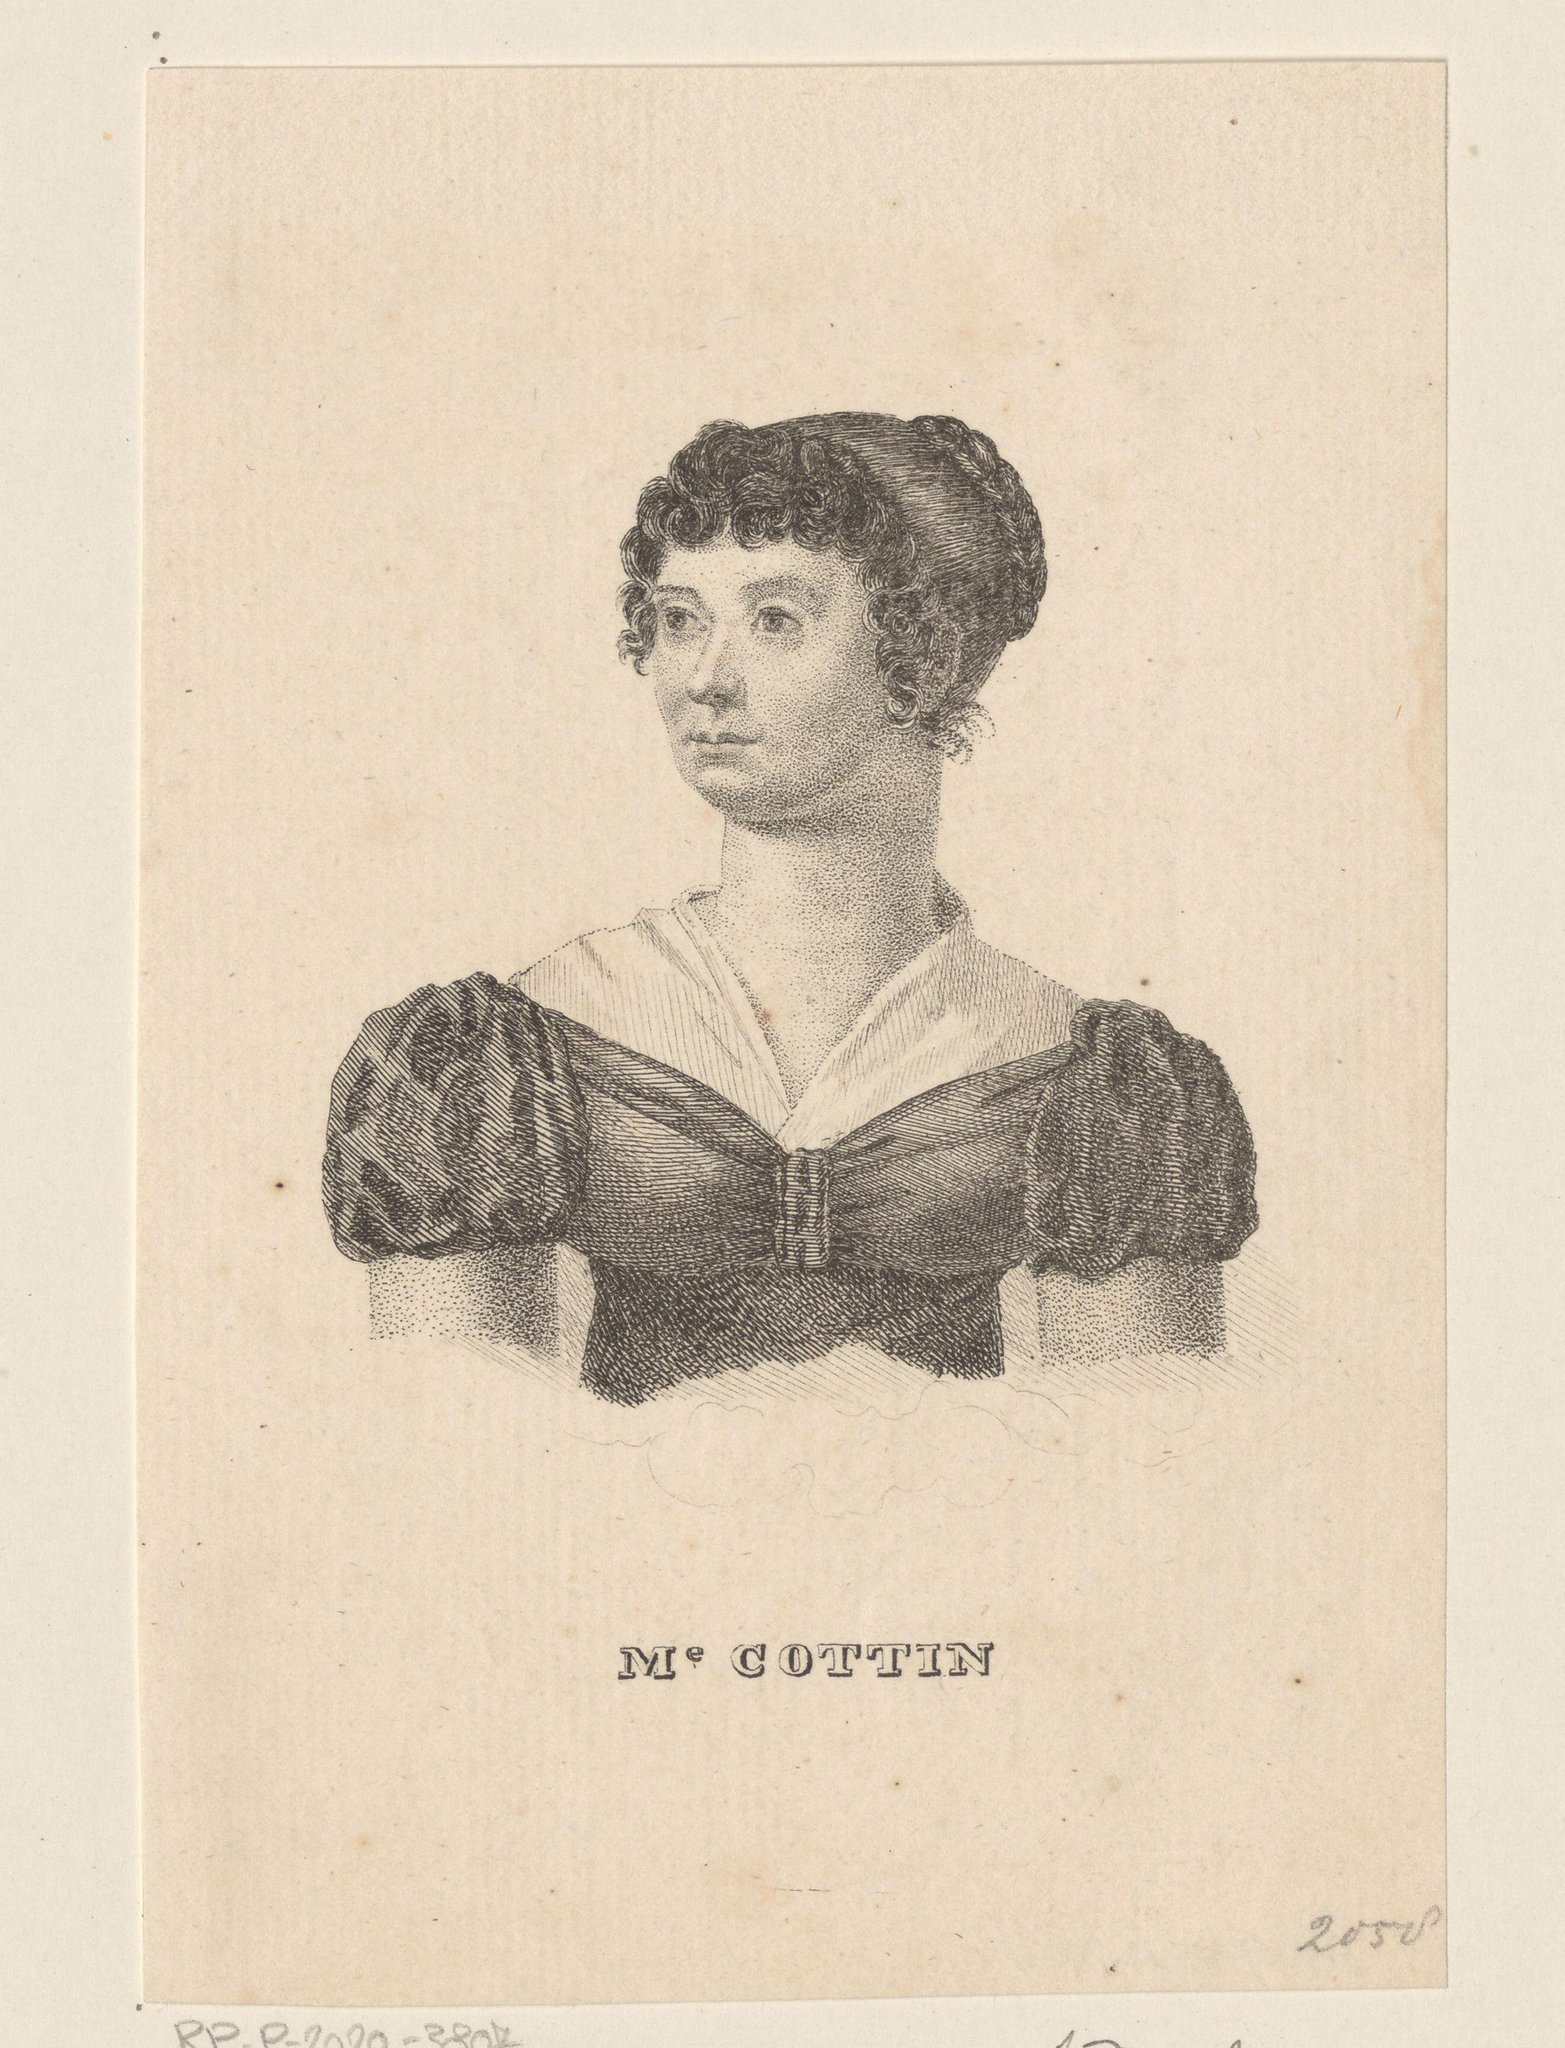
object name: print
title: Portret van Sophie Ristaud Cottin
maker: Anonymous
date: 1790-1849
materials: paper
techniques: etching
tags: historical persons - bb - woman